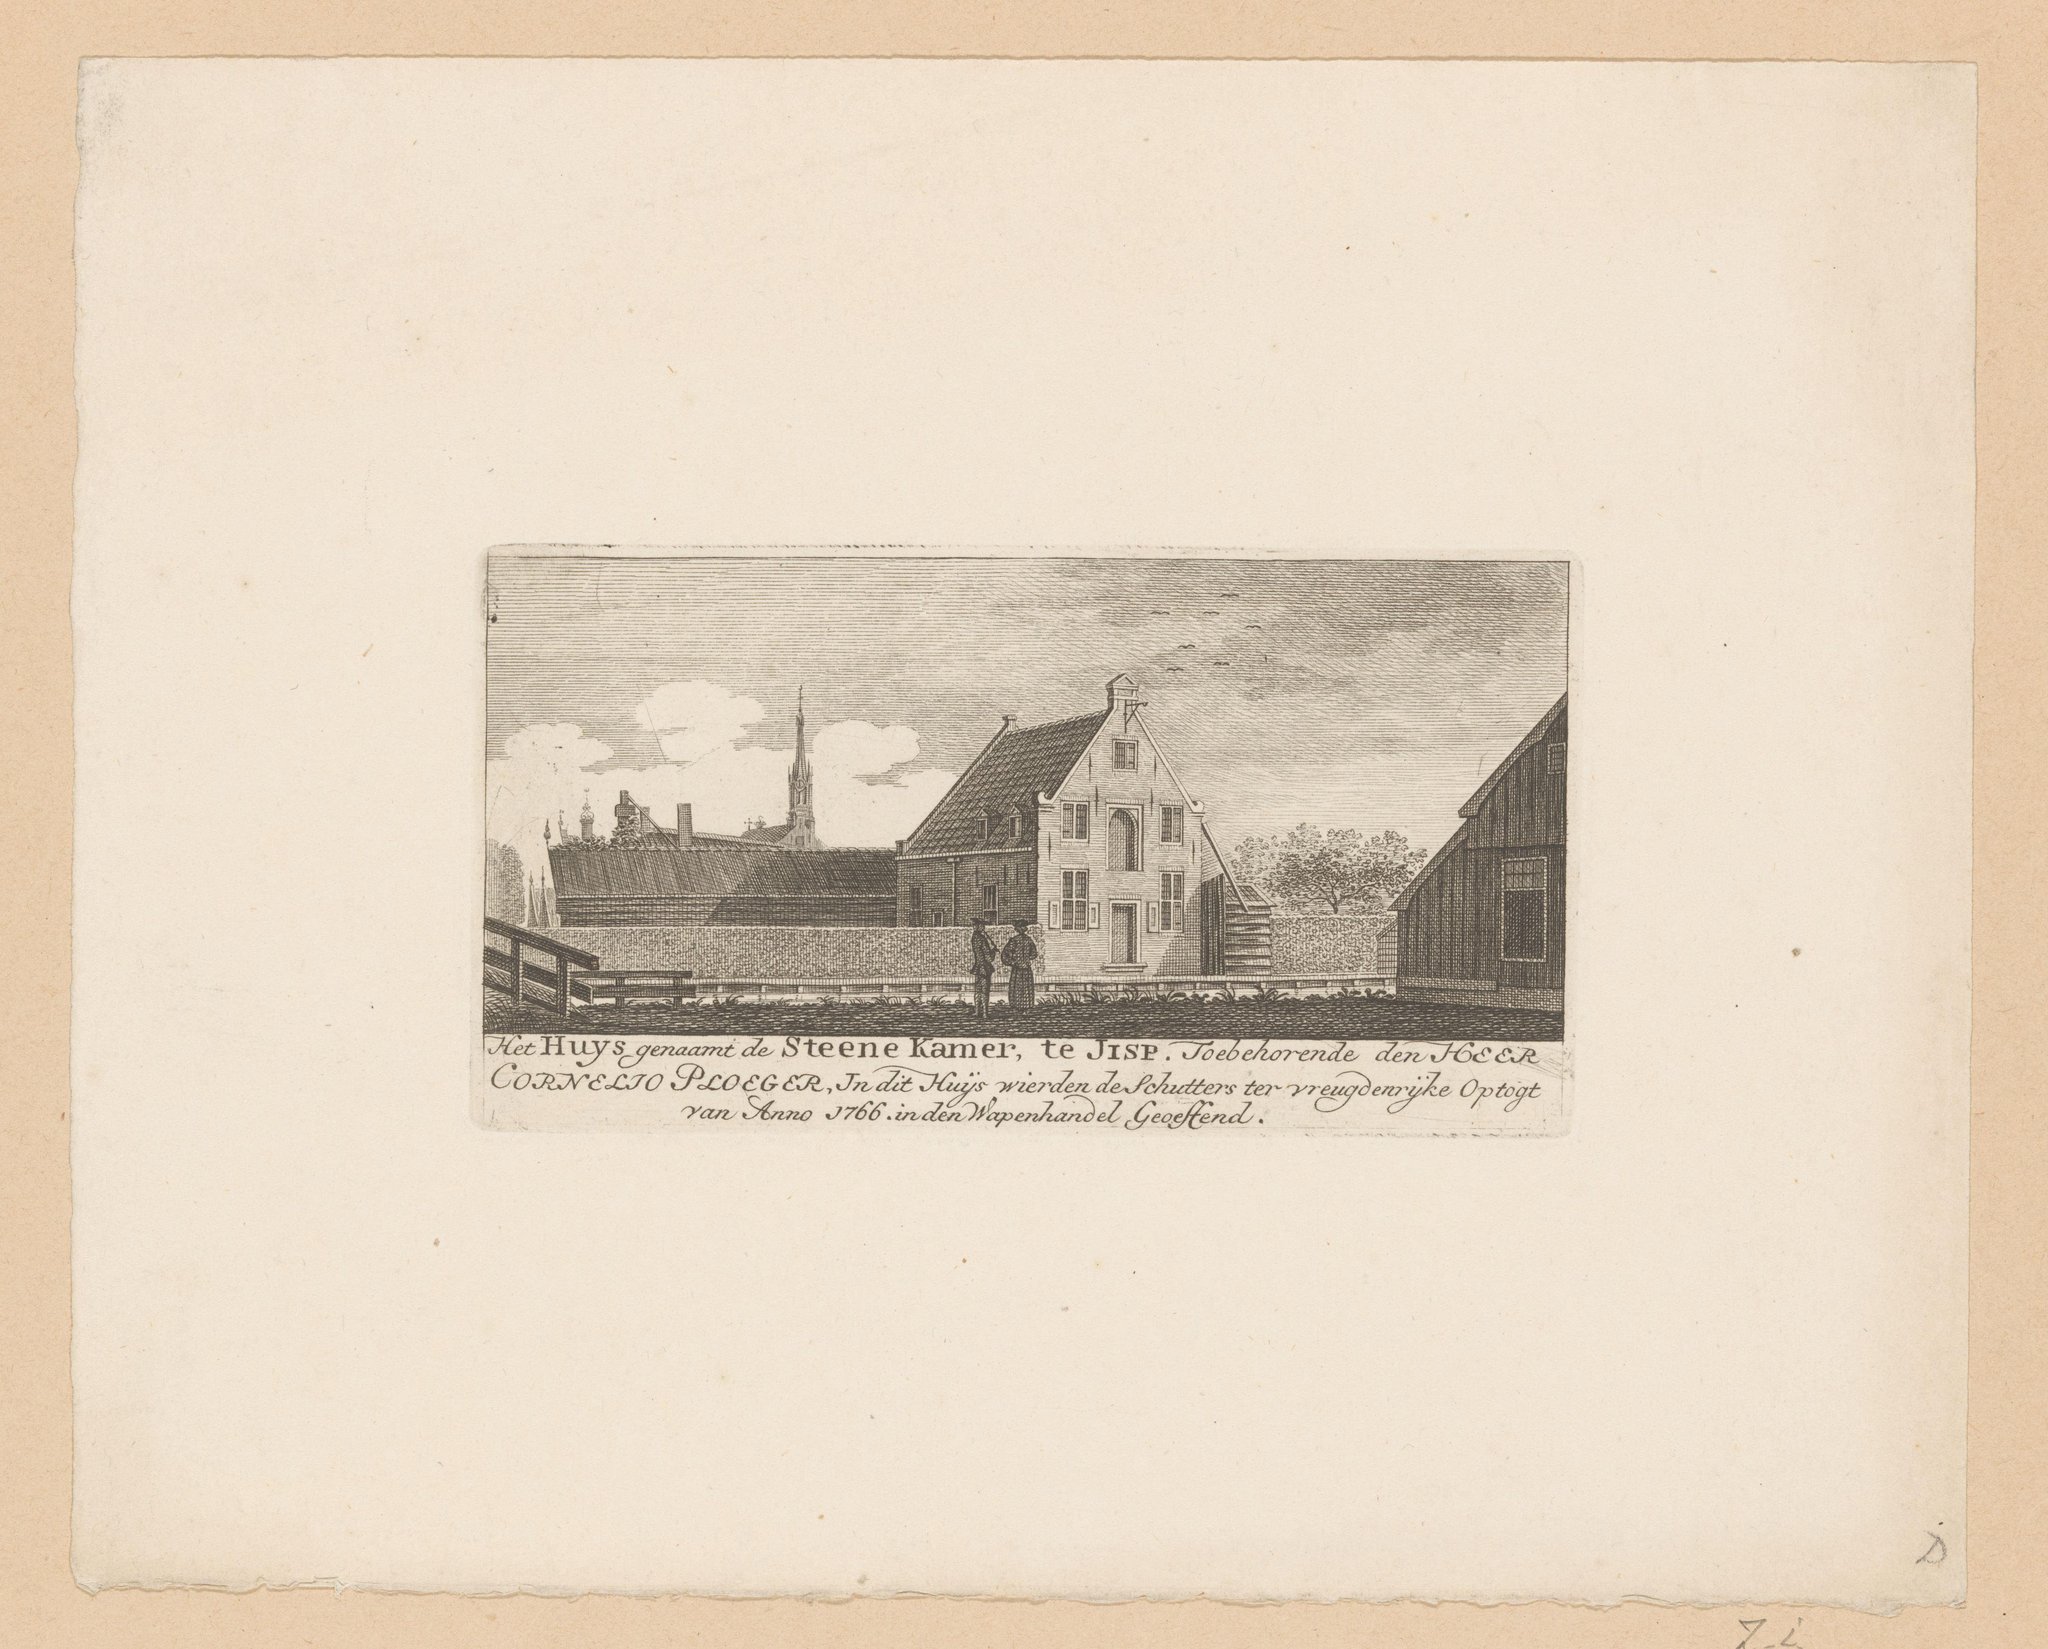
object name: print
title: Gezicht op het huis van Cornelis Ploeger in Jisp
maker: Anonymous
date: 1766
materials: paper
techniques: engraving, etching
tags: prospect of village, silhouette of village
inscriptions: date